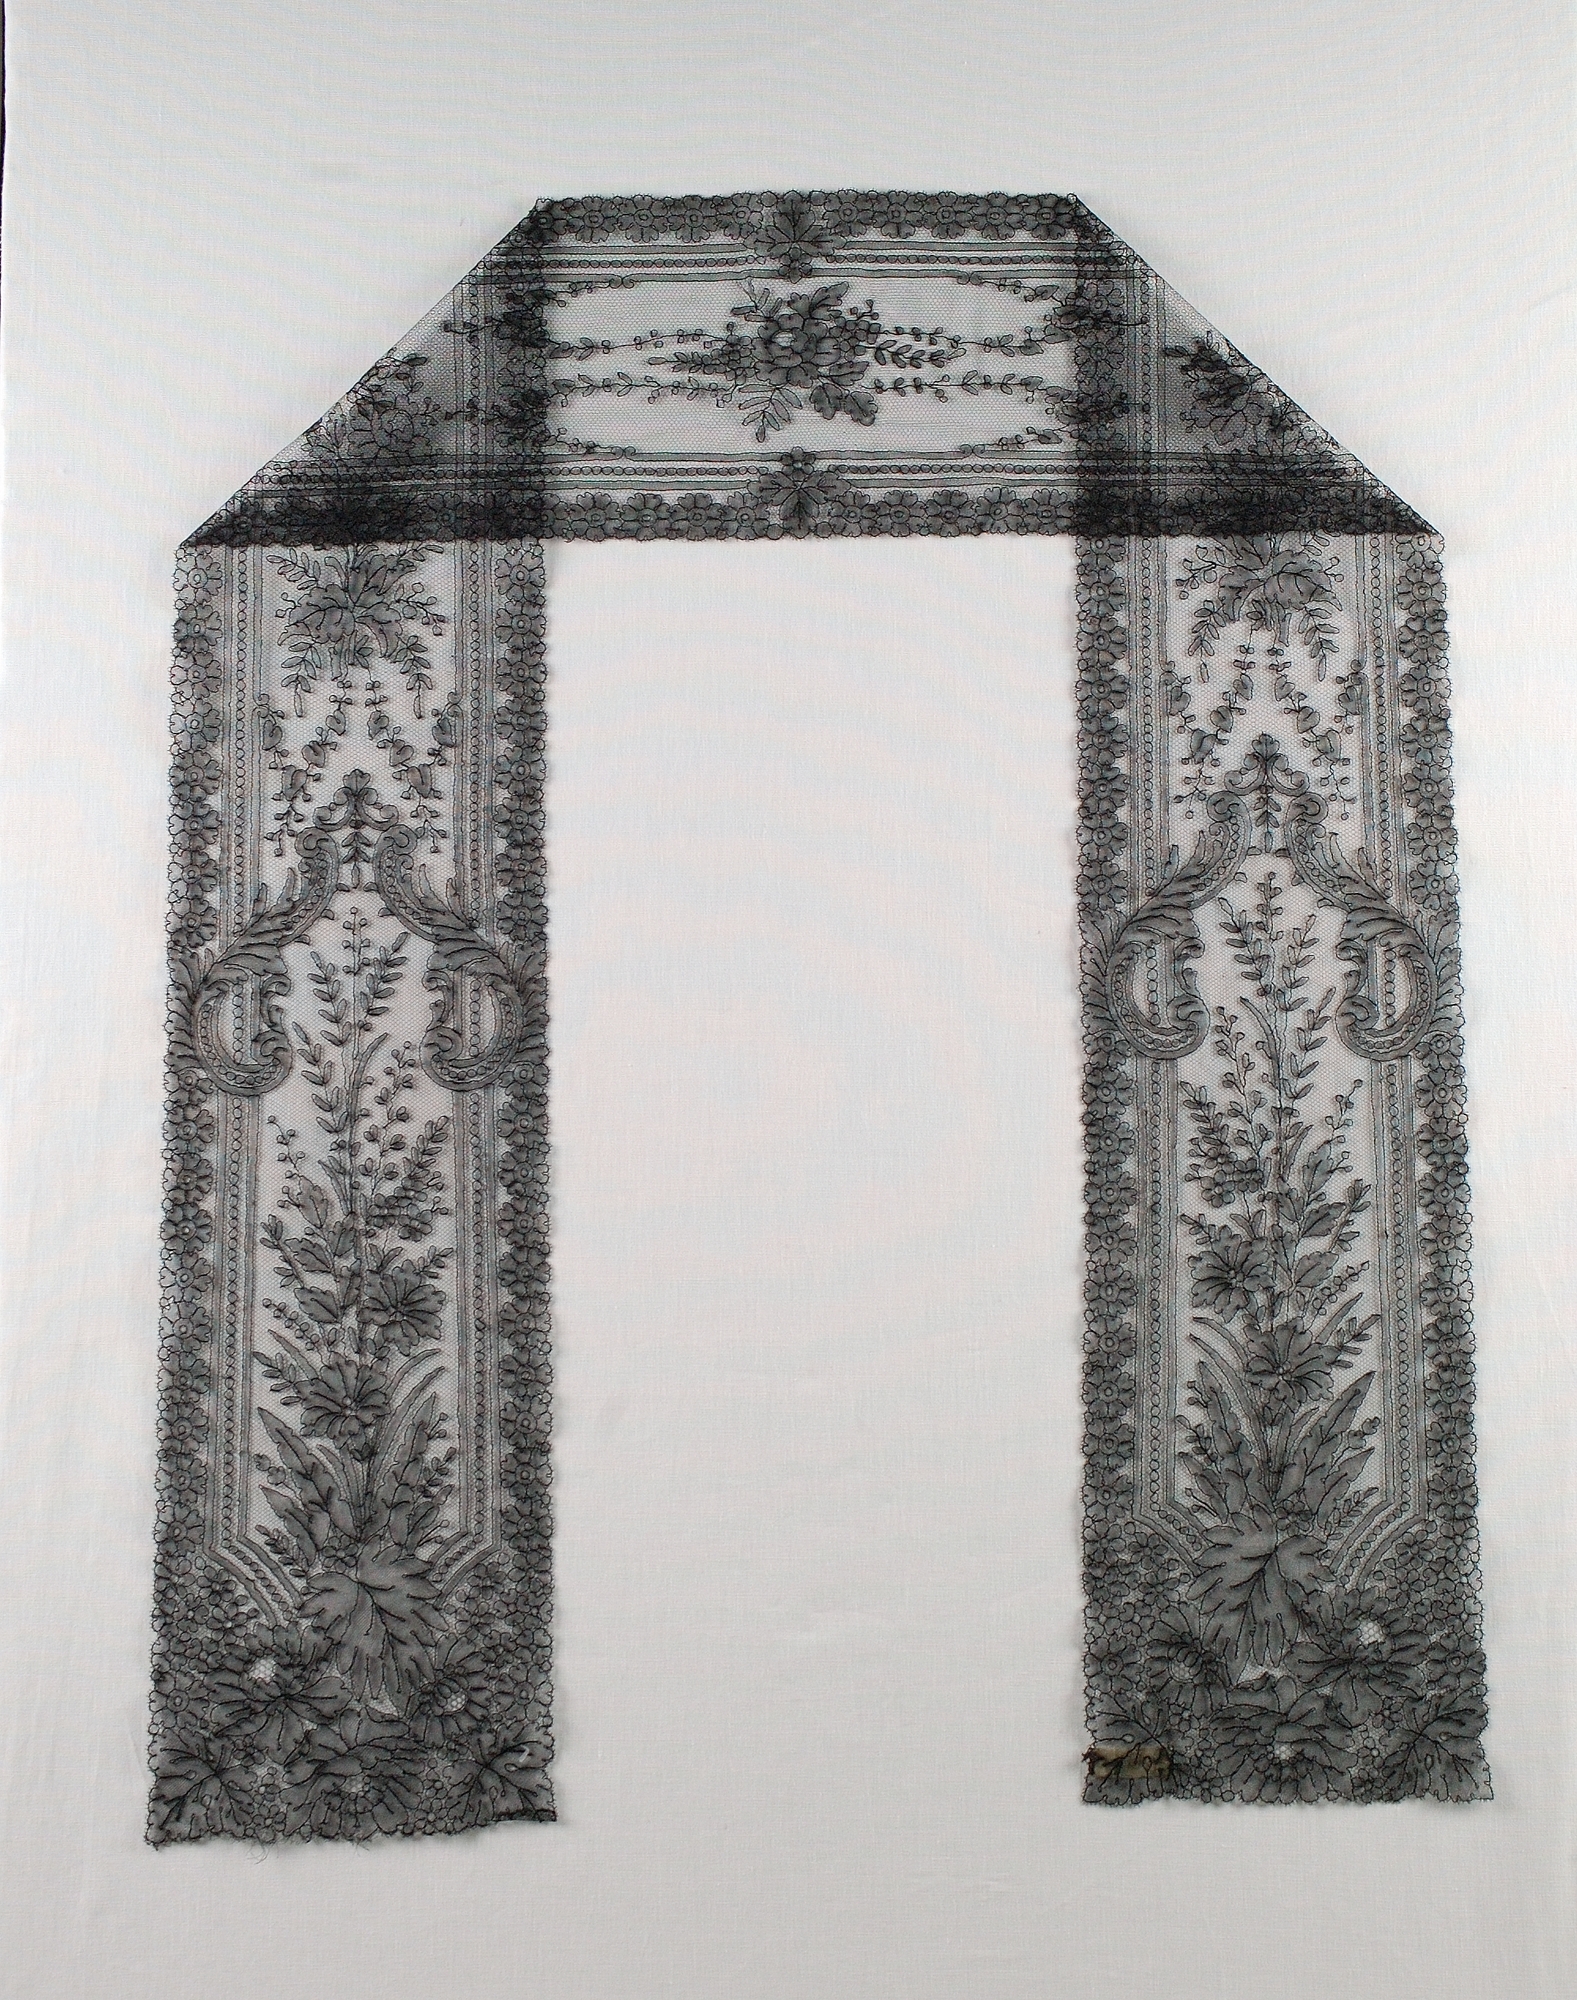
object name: lappet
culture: french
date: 1880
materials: silk